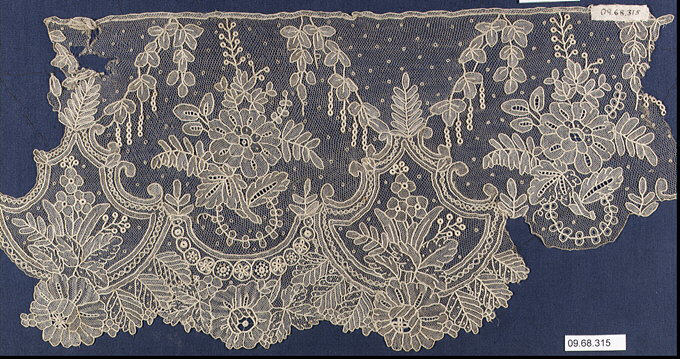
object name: specimen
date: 1801-1900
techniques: lace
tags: flowers